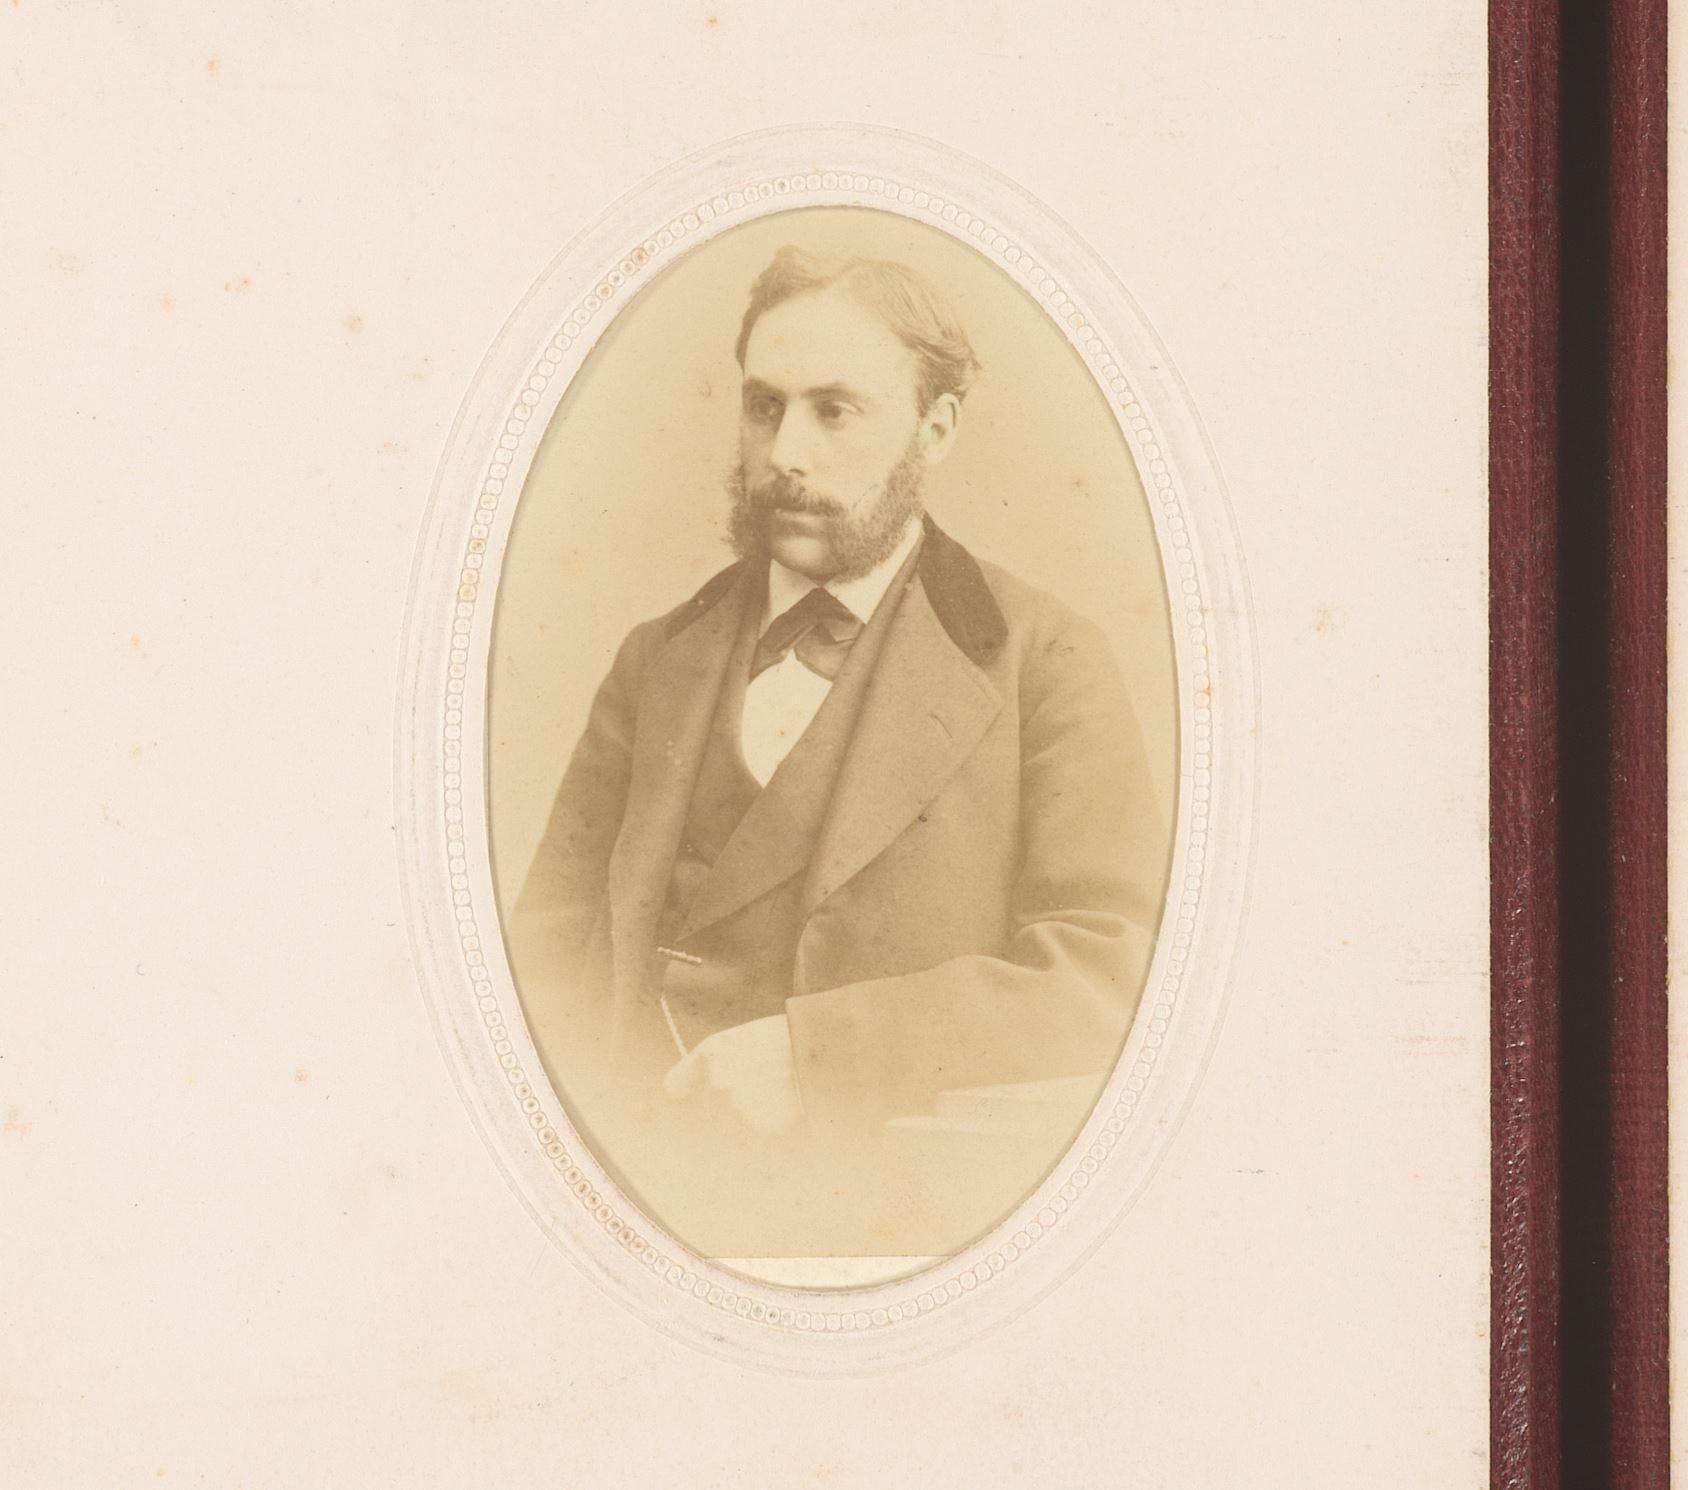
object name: carte de visite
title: Portret van een zittende man met bakkebaarden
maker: a. georges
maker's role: fotograaf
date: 1855-1880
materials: cardboard, paper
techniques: albumen print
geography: versailles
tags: sideburns, sitting figure, historical persons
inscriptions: inscription: ‘18 Rue de la Paroisse, Versailles’